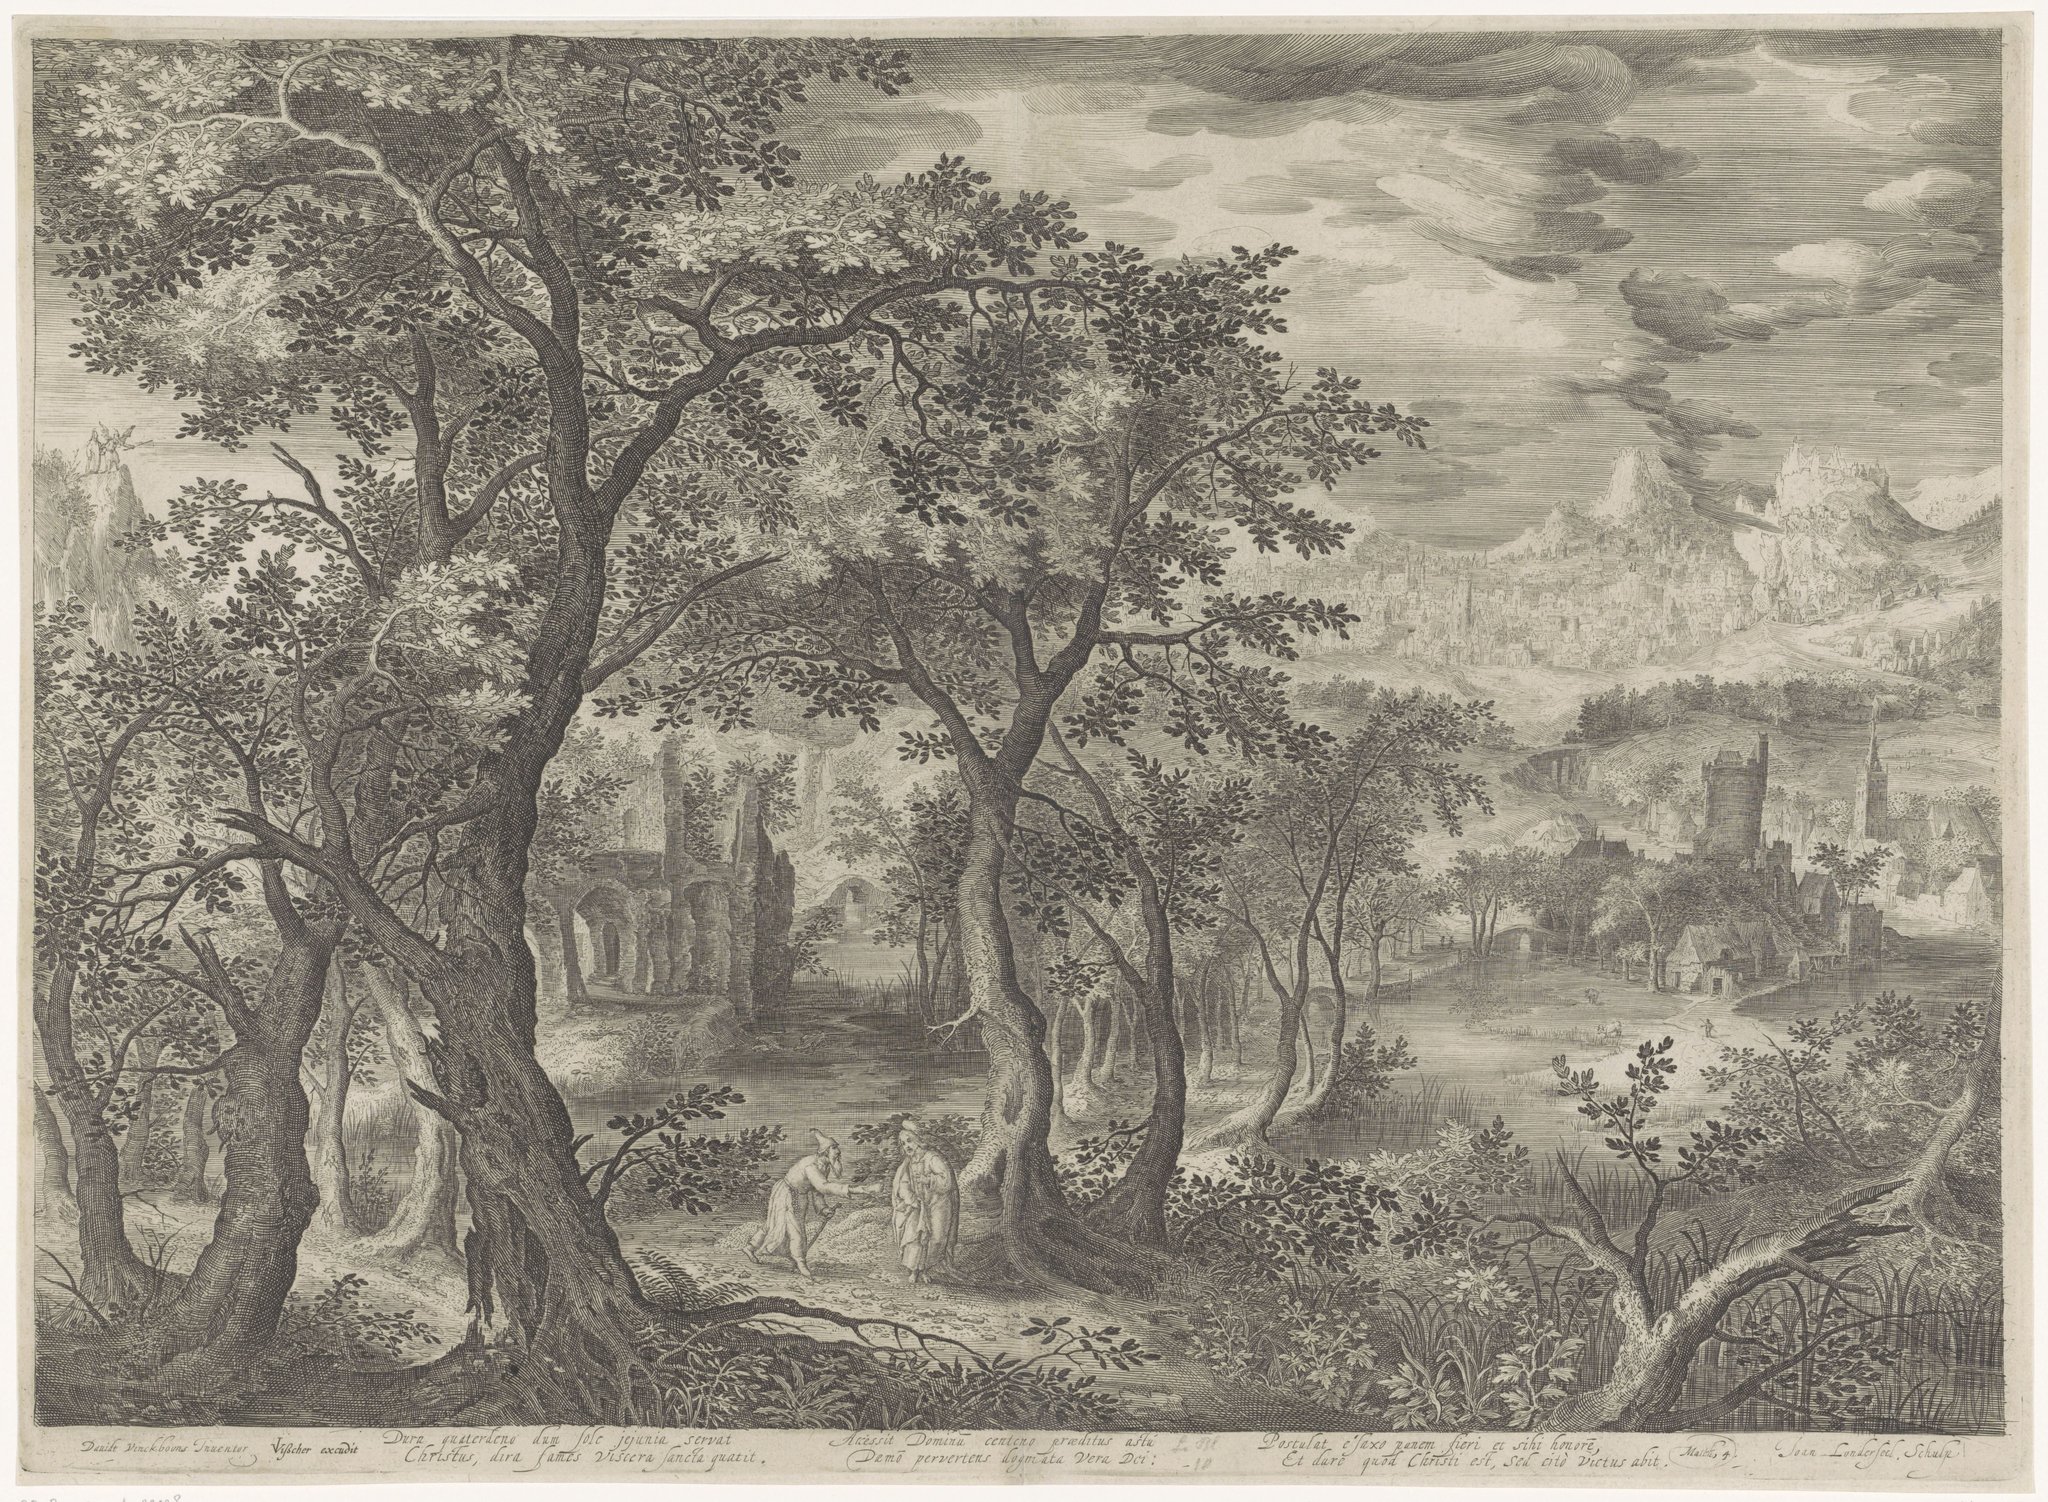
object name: print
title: Royaalbijbel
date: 1585-1625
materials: paper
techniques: engraving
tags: 'command these stones to become loaves of bread' ~ temptation of christ in the wilderness, mountains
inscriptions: collector's mark: Lugt 2228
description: De Amsterdamse uitgever Claes Jansz. Visscher (II) produceerde vanaf de jaren ’30 van de zeventiende eeuw grote Bijbelse prenten op zogenaamd royaal-formaat papier (ca. 480 x 580 mm). Na zijn dood in 1652 zette zijn zoon Nicolaes Visscher (I) het bedrijf voort en zo ook de uitgave van Royaalbijbelprenten. Toen Nicolaes in 1679 overleed nam zijn zoon Nicolaes Visscher (II) het bedrijf over en gaf kort hierna, omstreeks 1680, een fondslijst uit. Hierin worden 130 prenten met Bijbelse voorstellingen op royaalpapier beschreven (zie documentatie J. van der Waals). Complete prentbijbels op royaal-formaat werden door vader en zoon Nicolaes Visscher uitgegeven onder de titel Historiae Sacrae Veteris et Novi Testamenti. De bladen werden echter ook los verkocht en konden worden gecombineerd met Royaalbijbel-prenten van andere uitgevers. Verschillende Amsterdamse uitgevers brachten namelijk ook bijbelprenten op royaal-formaat uit, onder wie Clement de Jonghe en Cornelis Danckerts. De door de firma Visscher uitgegeven prenten zijn veelal vervaardigd door anonieme prentmakers naar voorbeeld van verschillende zestiende- en zeventiende-eeuwse Bijbelse prenten en prentreeksen. Veelal moesten de composities worden aangepast aan het grotere en langgerekte royaal-formaat. Daarnaast zijn er ook grote bladen van bekende prentmakers zoals Jan van Londerseel, Pieter Nolpe, Jacques de Gheyn (II) en Jan Harmensz. Muller opgenomen in de categorie ‘Bybelsche Figuren, op Royaal-bladen’ in de fondslijst van Visscher. Prent mogelijk gebruikt in: Historiae Sacrae Veteris et Novi Testamenti (Royaalbijbel). Amsterdam: Nicolaes Visscher (I) en (II), [1652-1702]. In de fondslijst van Nicolaes Visscher II (ca. 1680) is het onderwerp van deze prent onder de titel 'Bybelsche Figuren, op Royaal-bladen. bestaande uyt de volgende historien.' als volgt genummerd: 75.